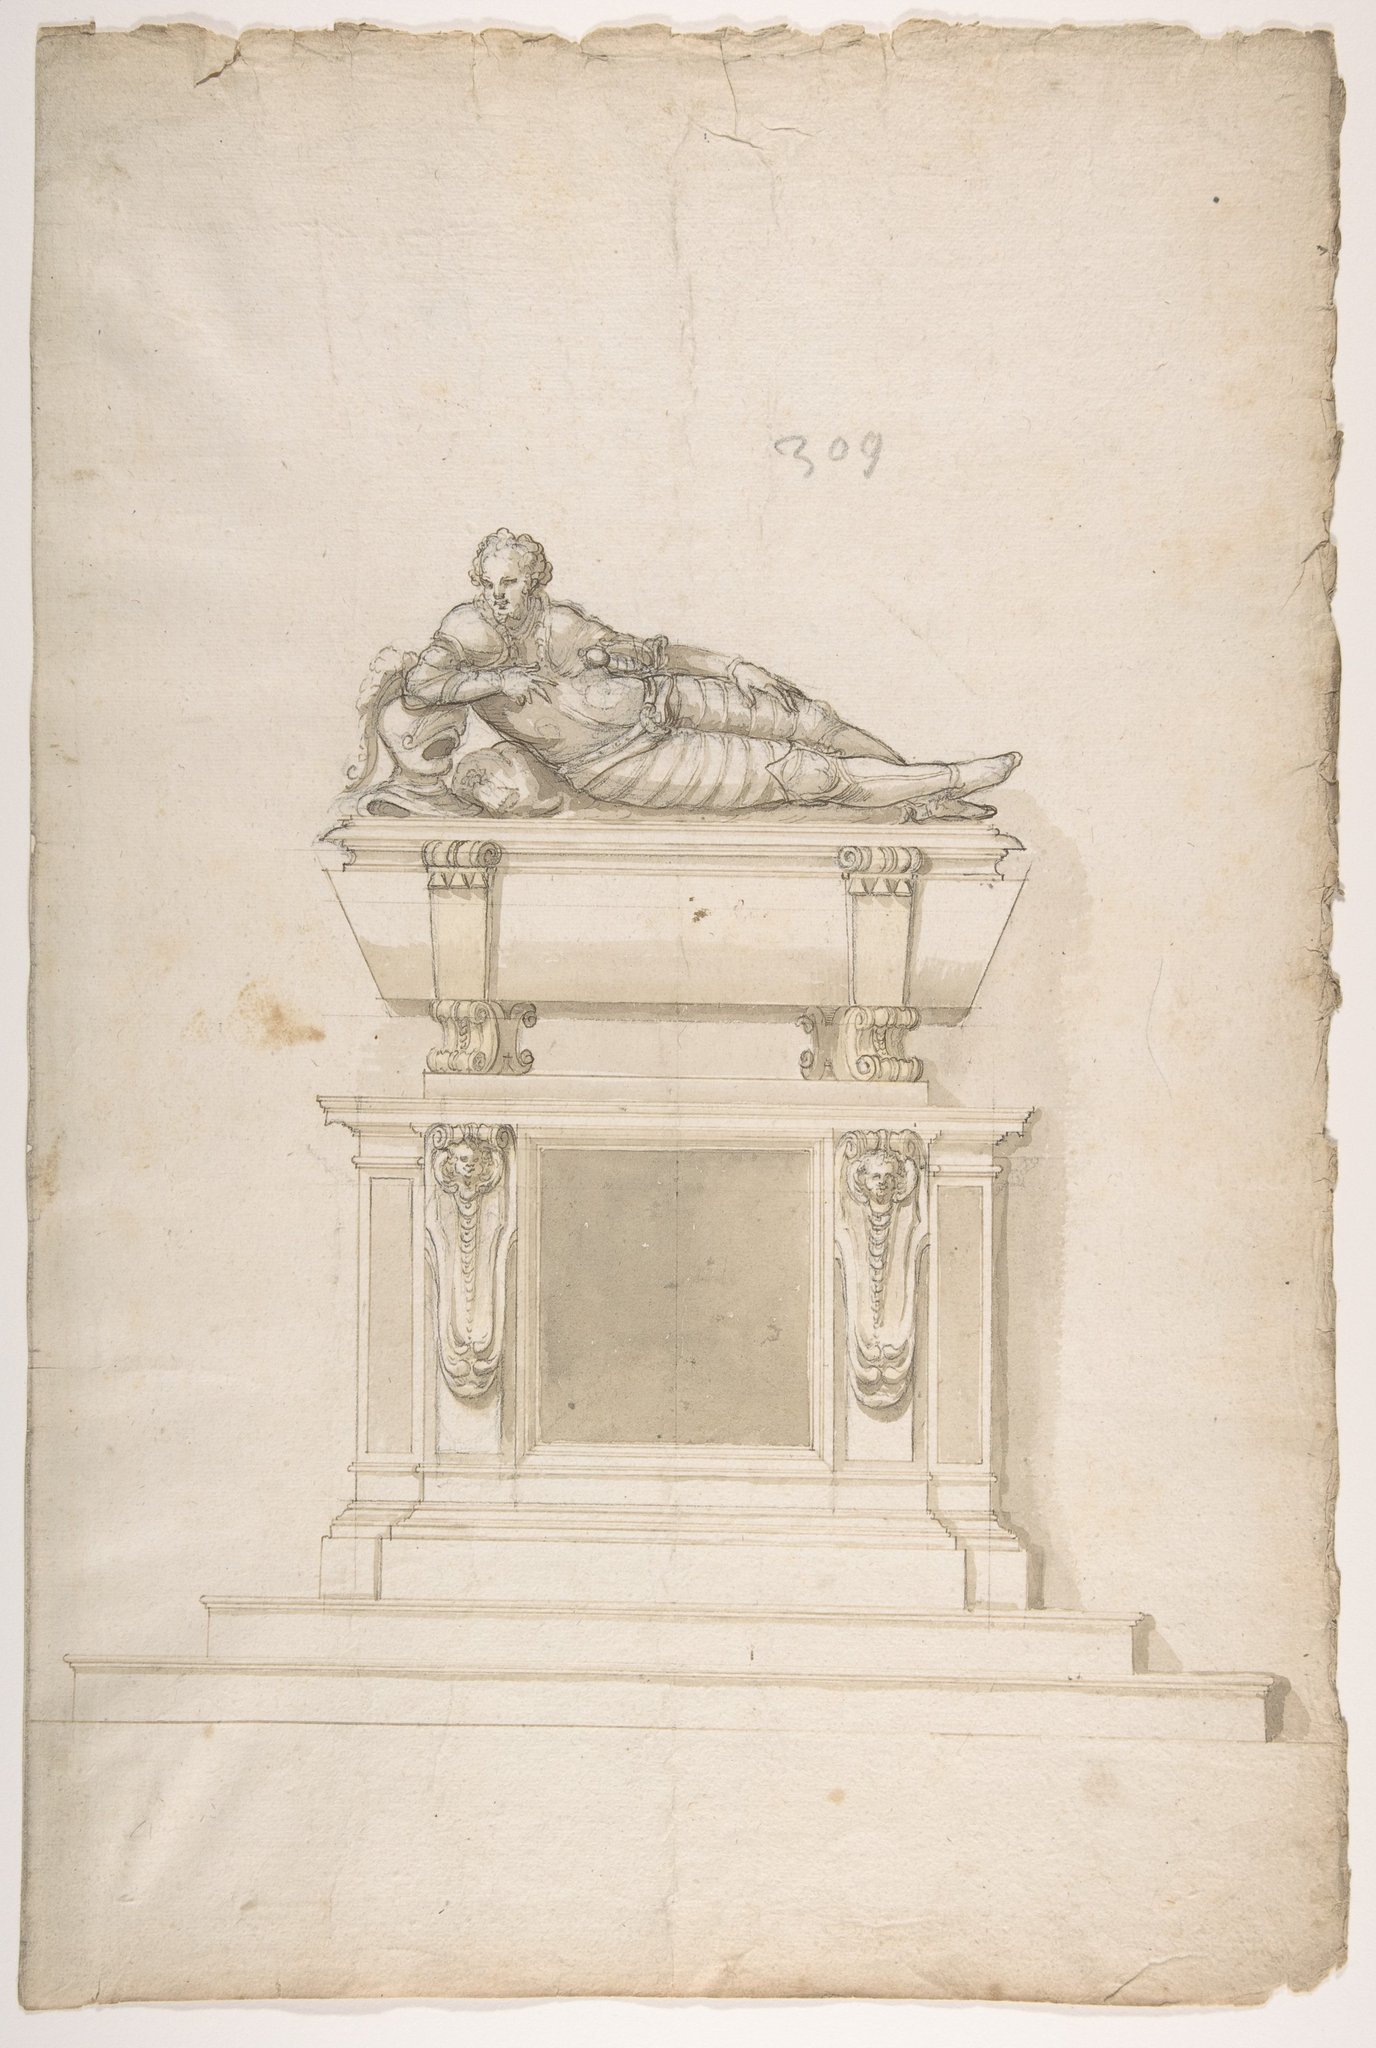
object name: drawing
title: Design for a Man's Tomb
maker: anonymous, french, 16th century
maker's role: artist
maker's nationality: french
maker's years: 1500-1600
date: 1501-1600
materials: chalk, ink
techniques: brush, pen, wash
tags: tombs,men